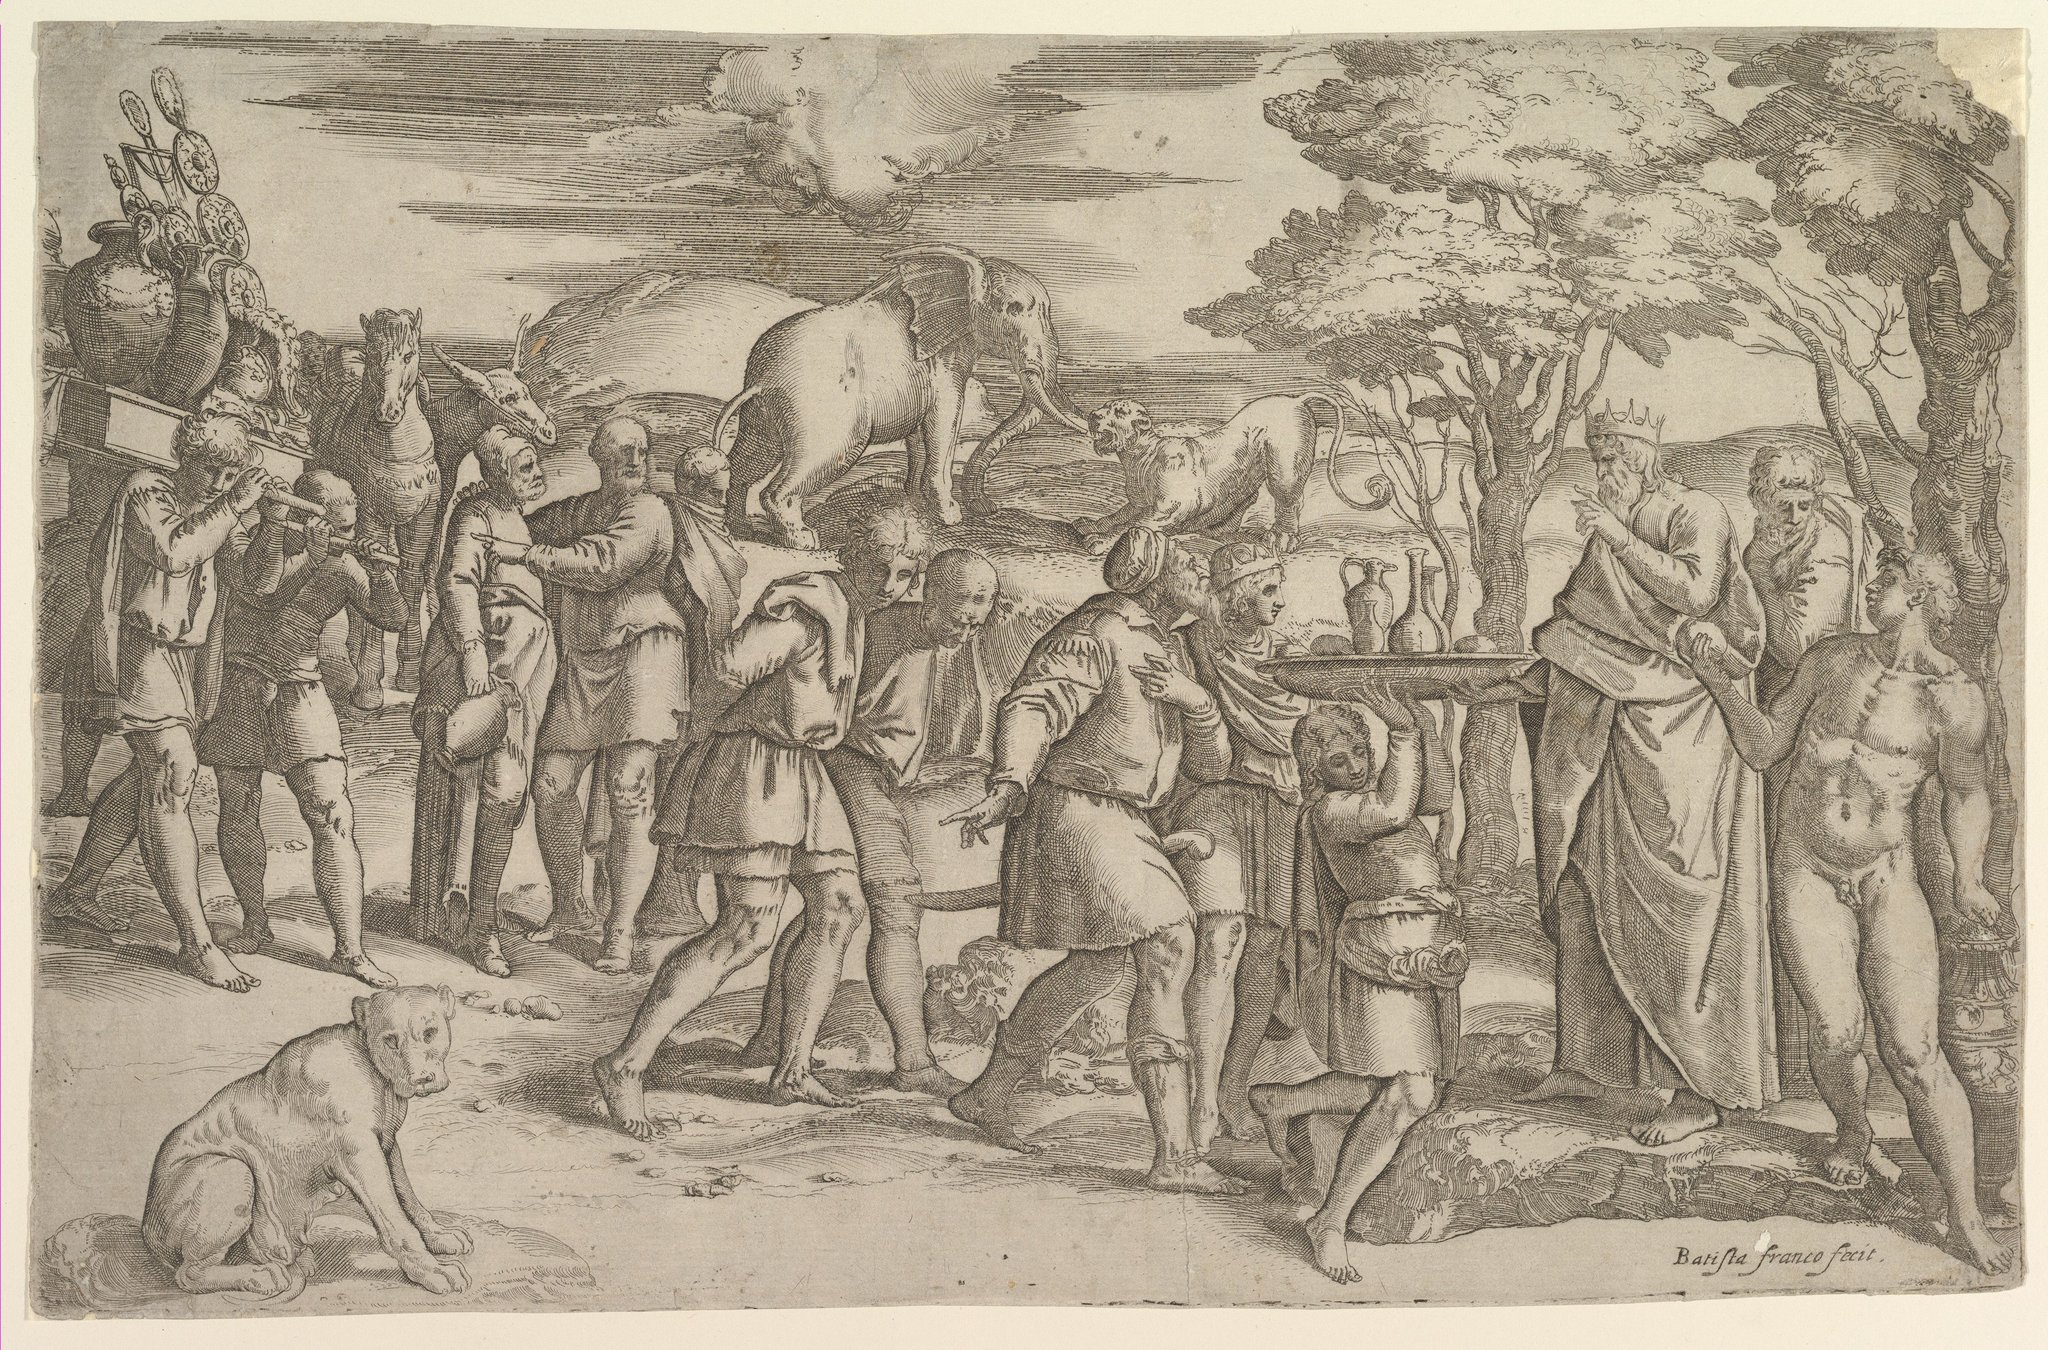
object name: print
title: Melchizadek offering bread and wine to Abraham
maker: battista franco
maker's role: artist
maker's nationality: italian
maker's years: 1510-1561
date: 1545-1561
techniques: engraving, etching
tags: bread,wine,dogs,elephants,lions,abraham